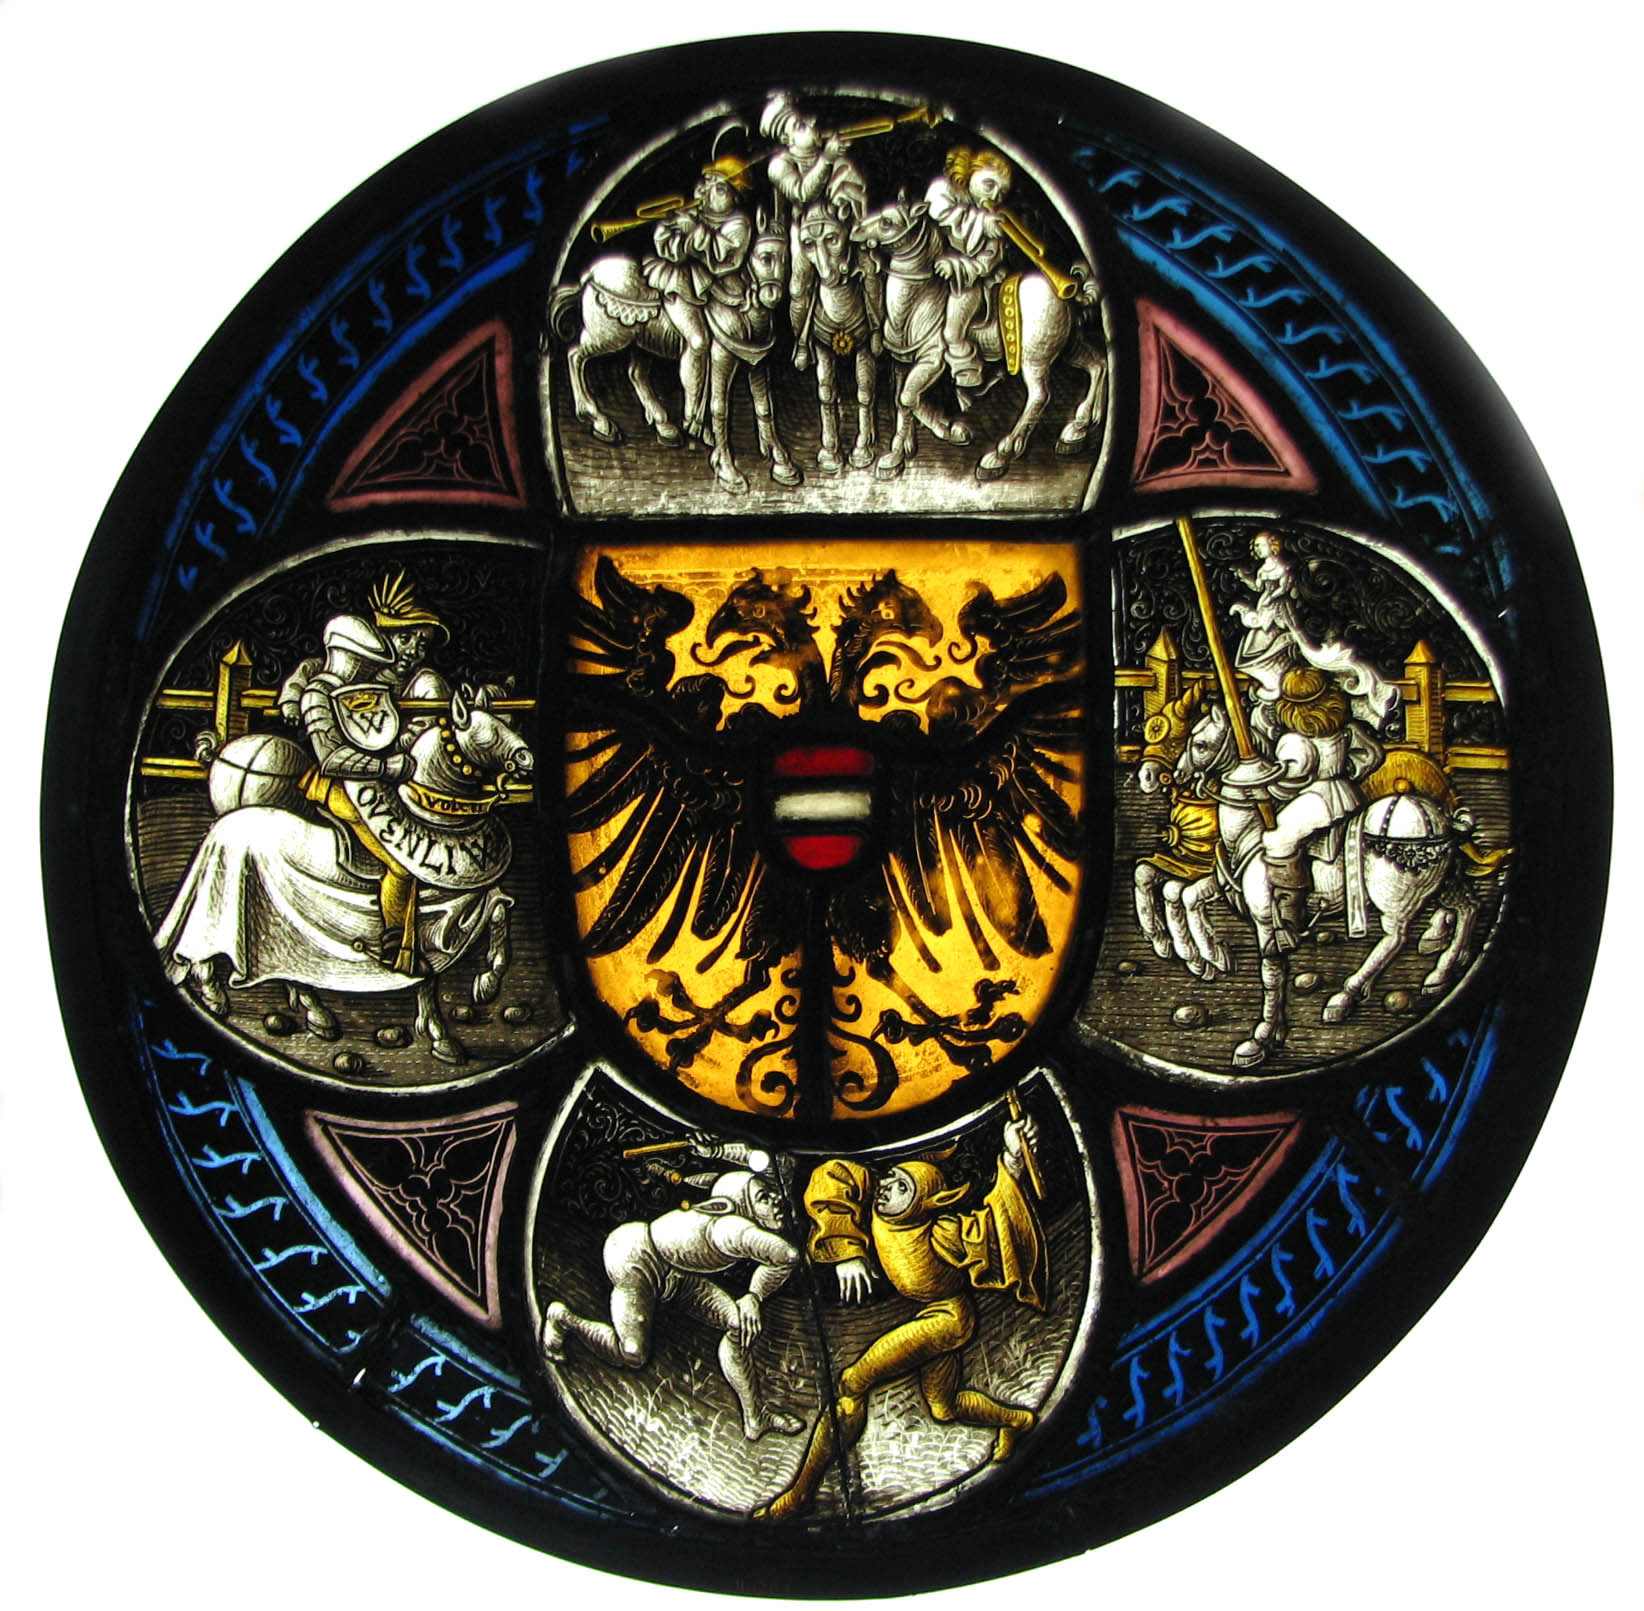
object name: roundel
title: Quatrefoil Roundel with Arms and Secular Scenes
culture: german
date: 1490-1500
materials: glass, metal, paint, pigment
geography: germany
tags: eagles,men,horses,coat of arms,musicians